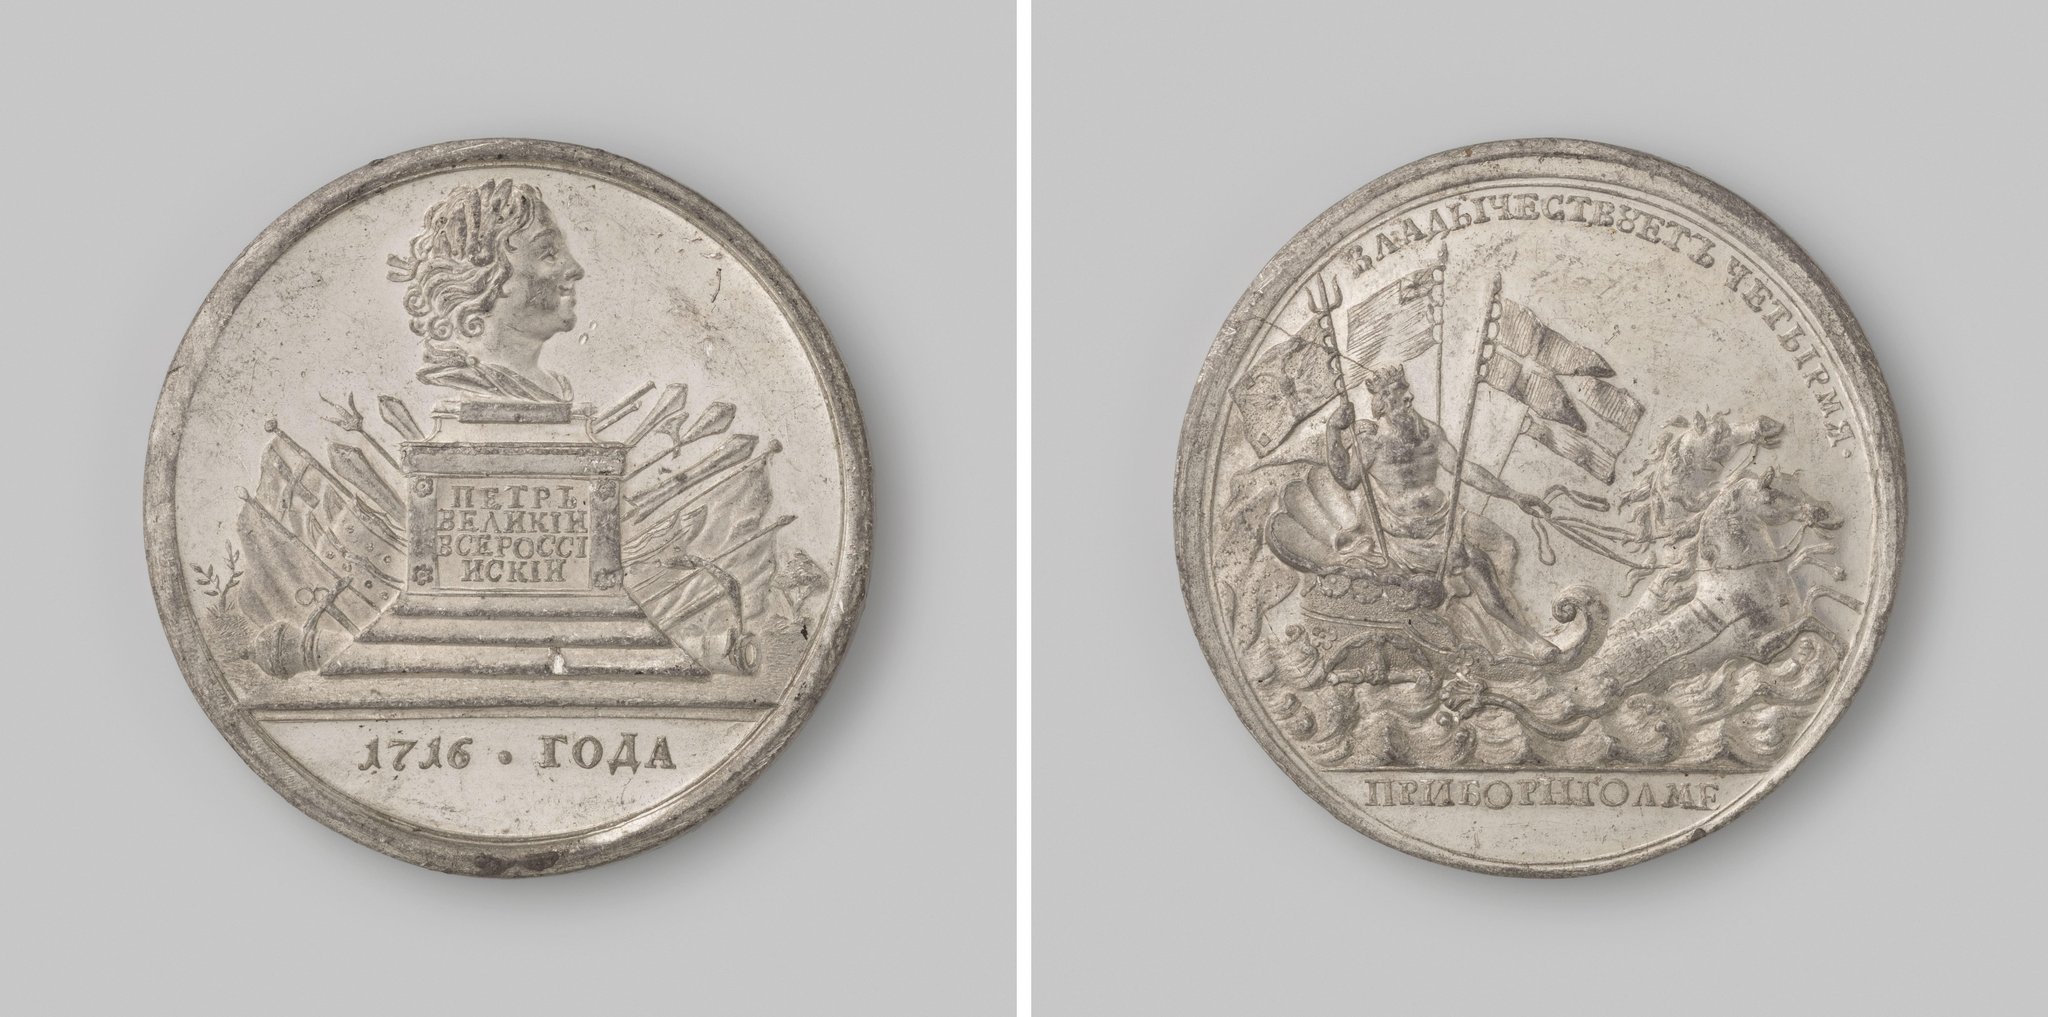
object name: history medal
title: Tsaar Peter I van Rusland hoofd van de verenigde vloten 1716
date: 1716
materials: tin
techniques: striking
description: Tinnen penning, op de voorzijde het borstbeeld van Tsaar Peter de Grote naar rechts met omschrift, op de keerzijde Neptunus met vier vlaggen in zijn strijdwagen, met omschrift en afsnedetekst.